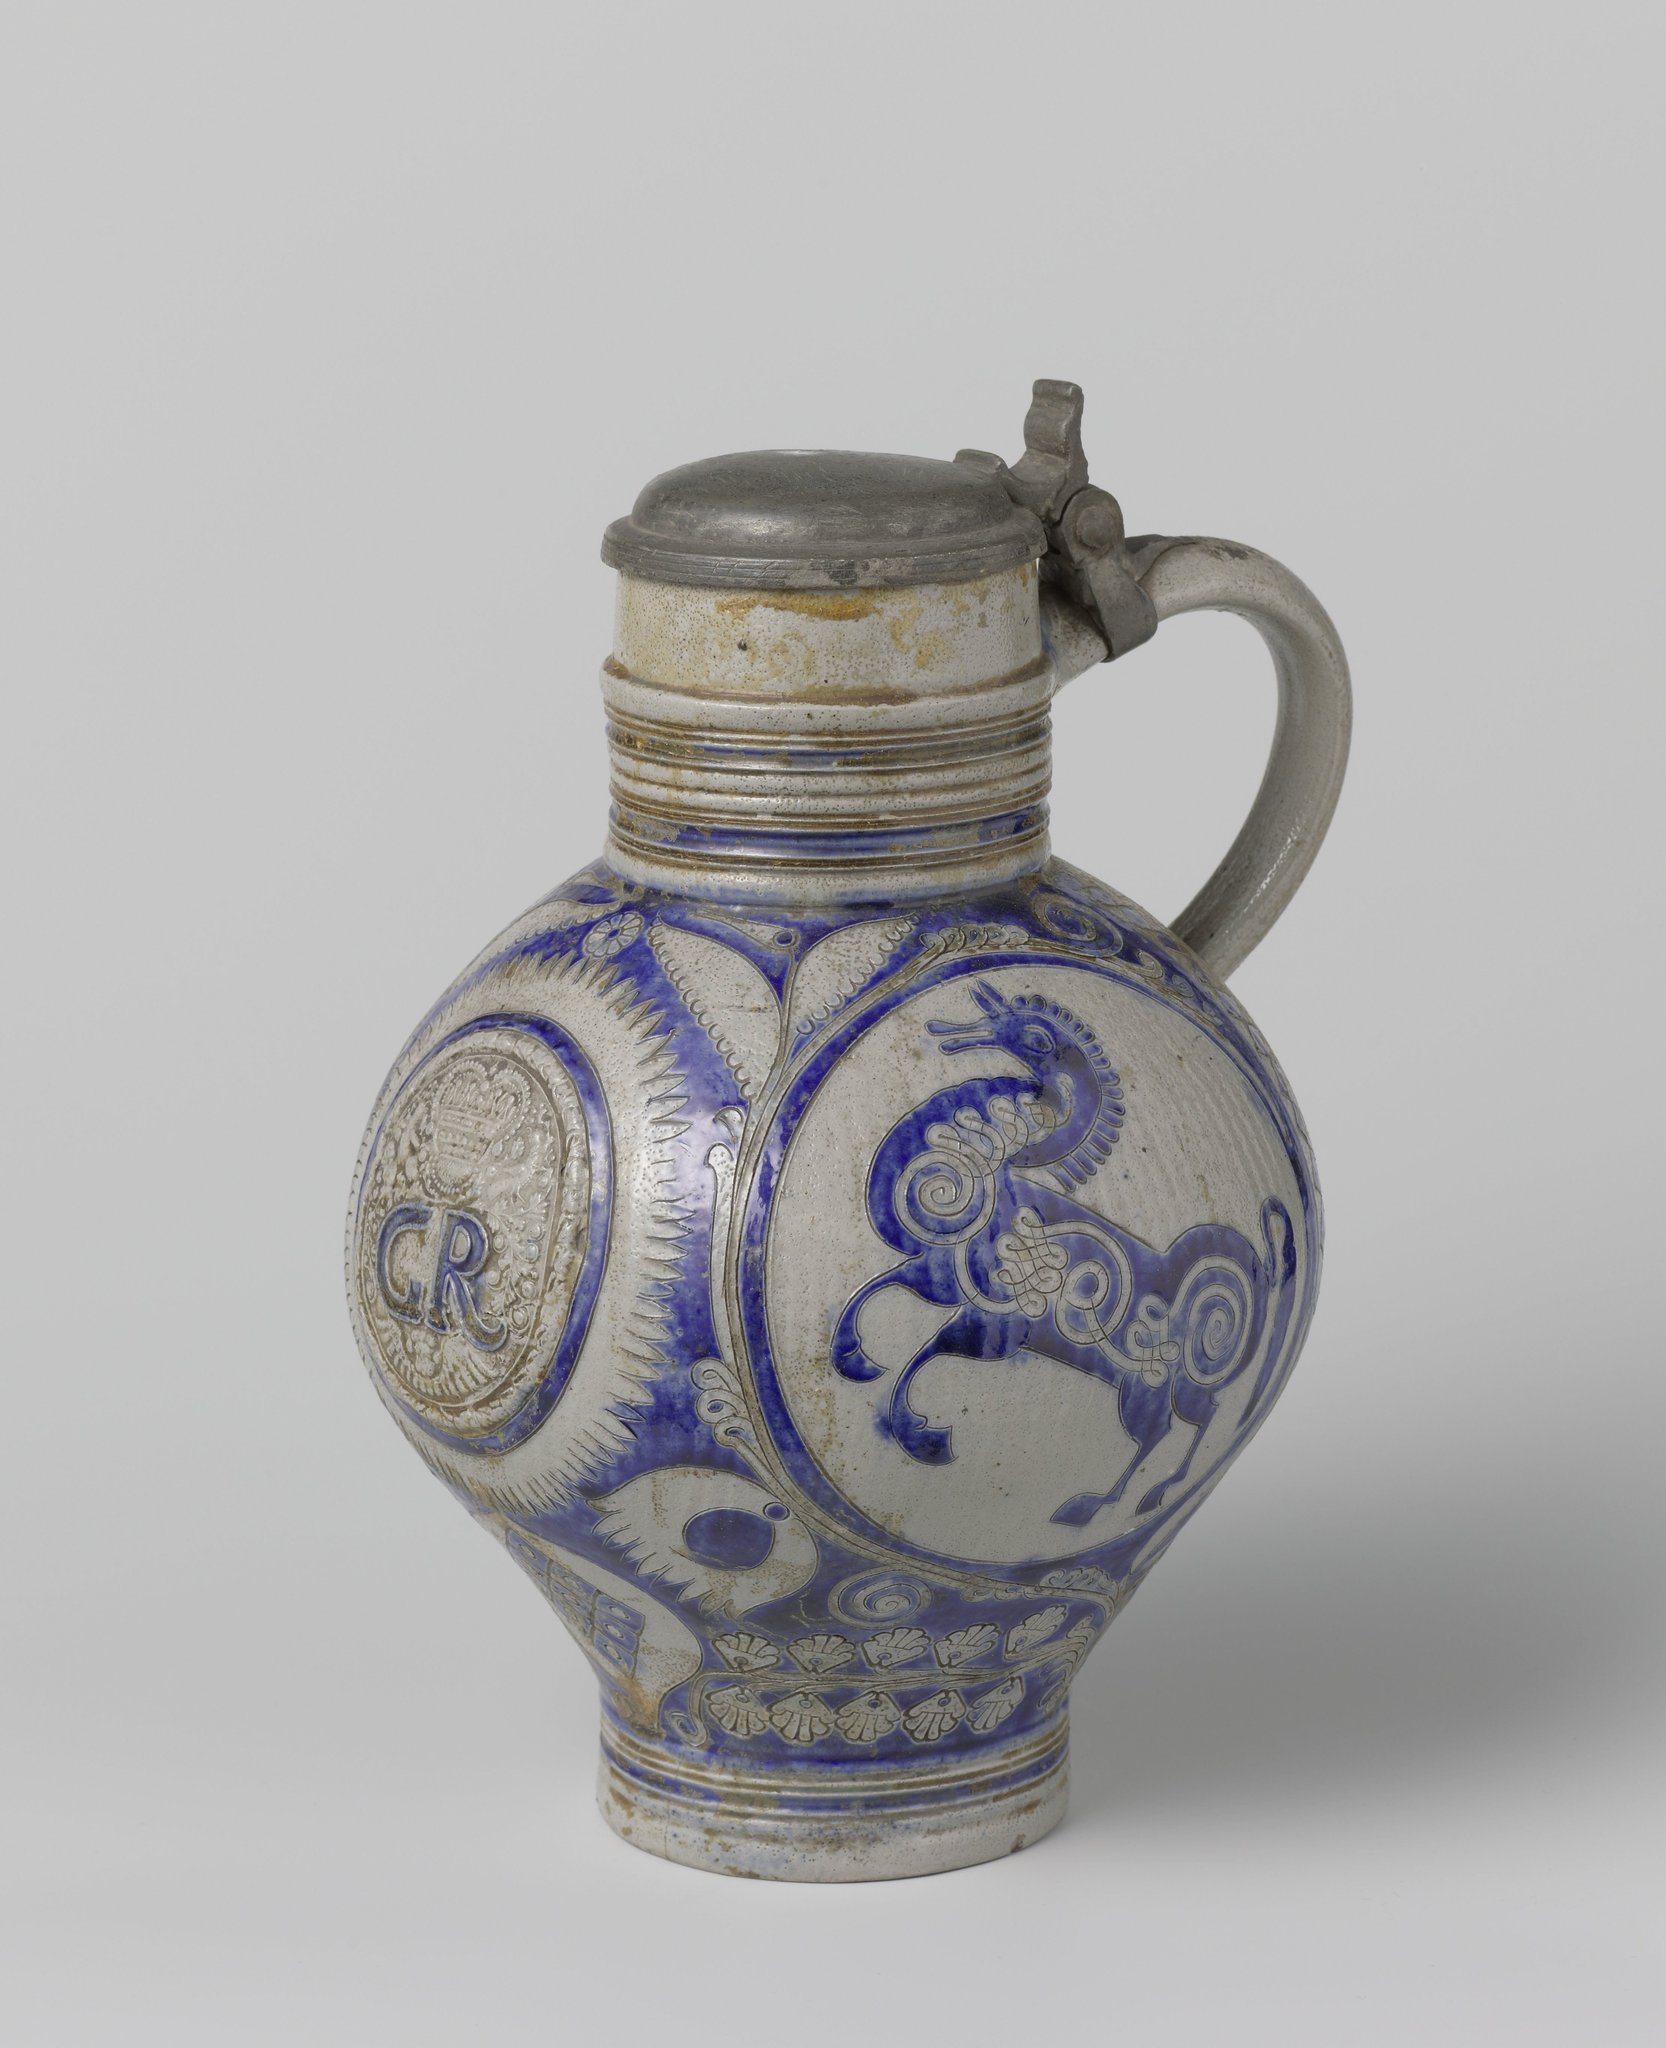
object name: jug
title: Jug with the monogram 'GR' and horses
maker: Anonymous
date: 1710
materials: cobalt, glaze, stoneware, tin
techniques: printing, firing, forming, turning, vitrification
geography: westerwald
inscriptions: inscription: ‘GR’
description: Kruik van steengoed op hoge voet met een bolvormig lichaam en wijde nek. Het C-vormige oor is bevestigd aan de nek en de schouder. Enkele profielen op de nek en voet. Gedeeltelijk bedekt met kobaltblauw. Op de buik in reliëf een gedrukt en opgelegd monogram 'GR' (George Rex, ofwel Koning George van Engeland) in een medaillon met een rkoon, vogels en bloemranken. Aan weerszijden van het monogram een ingegrift medaillon met een steigerend paard. Bloemranken tussen de vakken. Aan het oor is een tinnen montuur met deksel bevestigd. Op de binnenzijde een geslagen merk (onleesbaar). Westerwald.